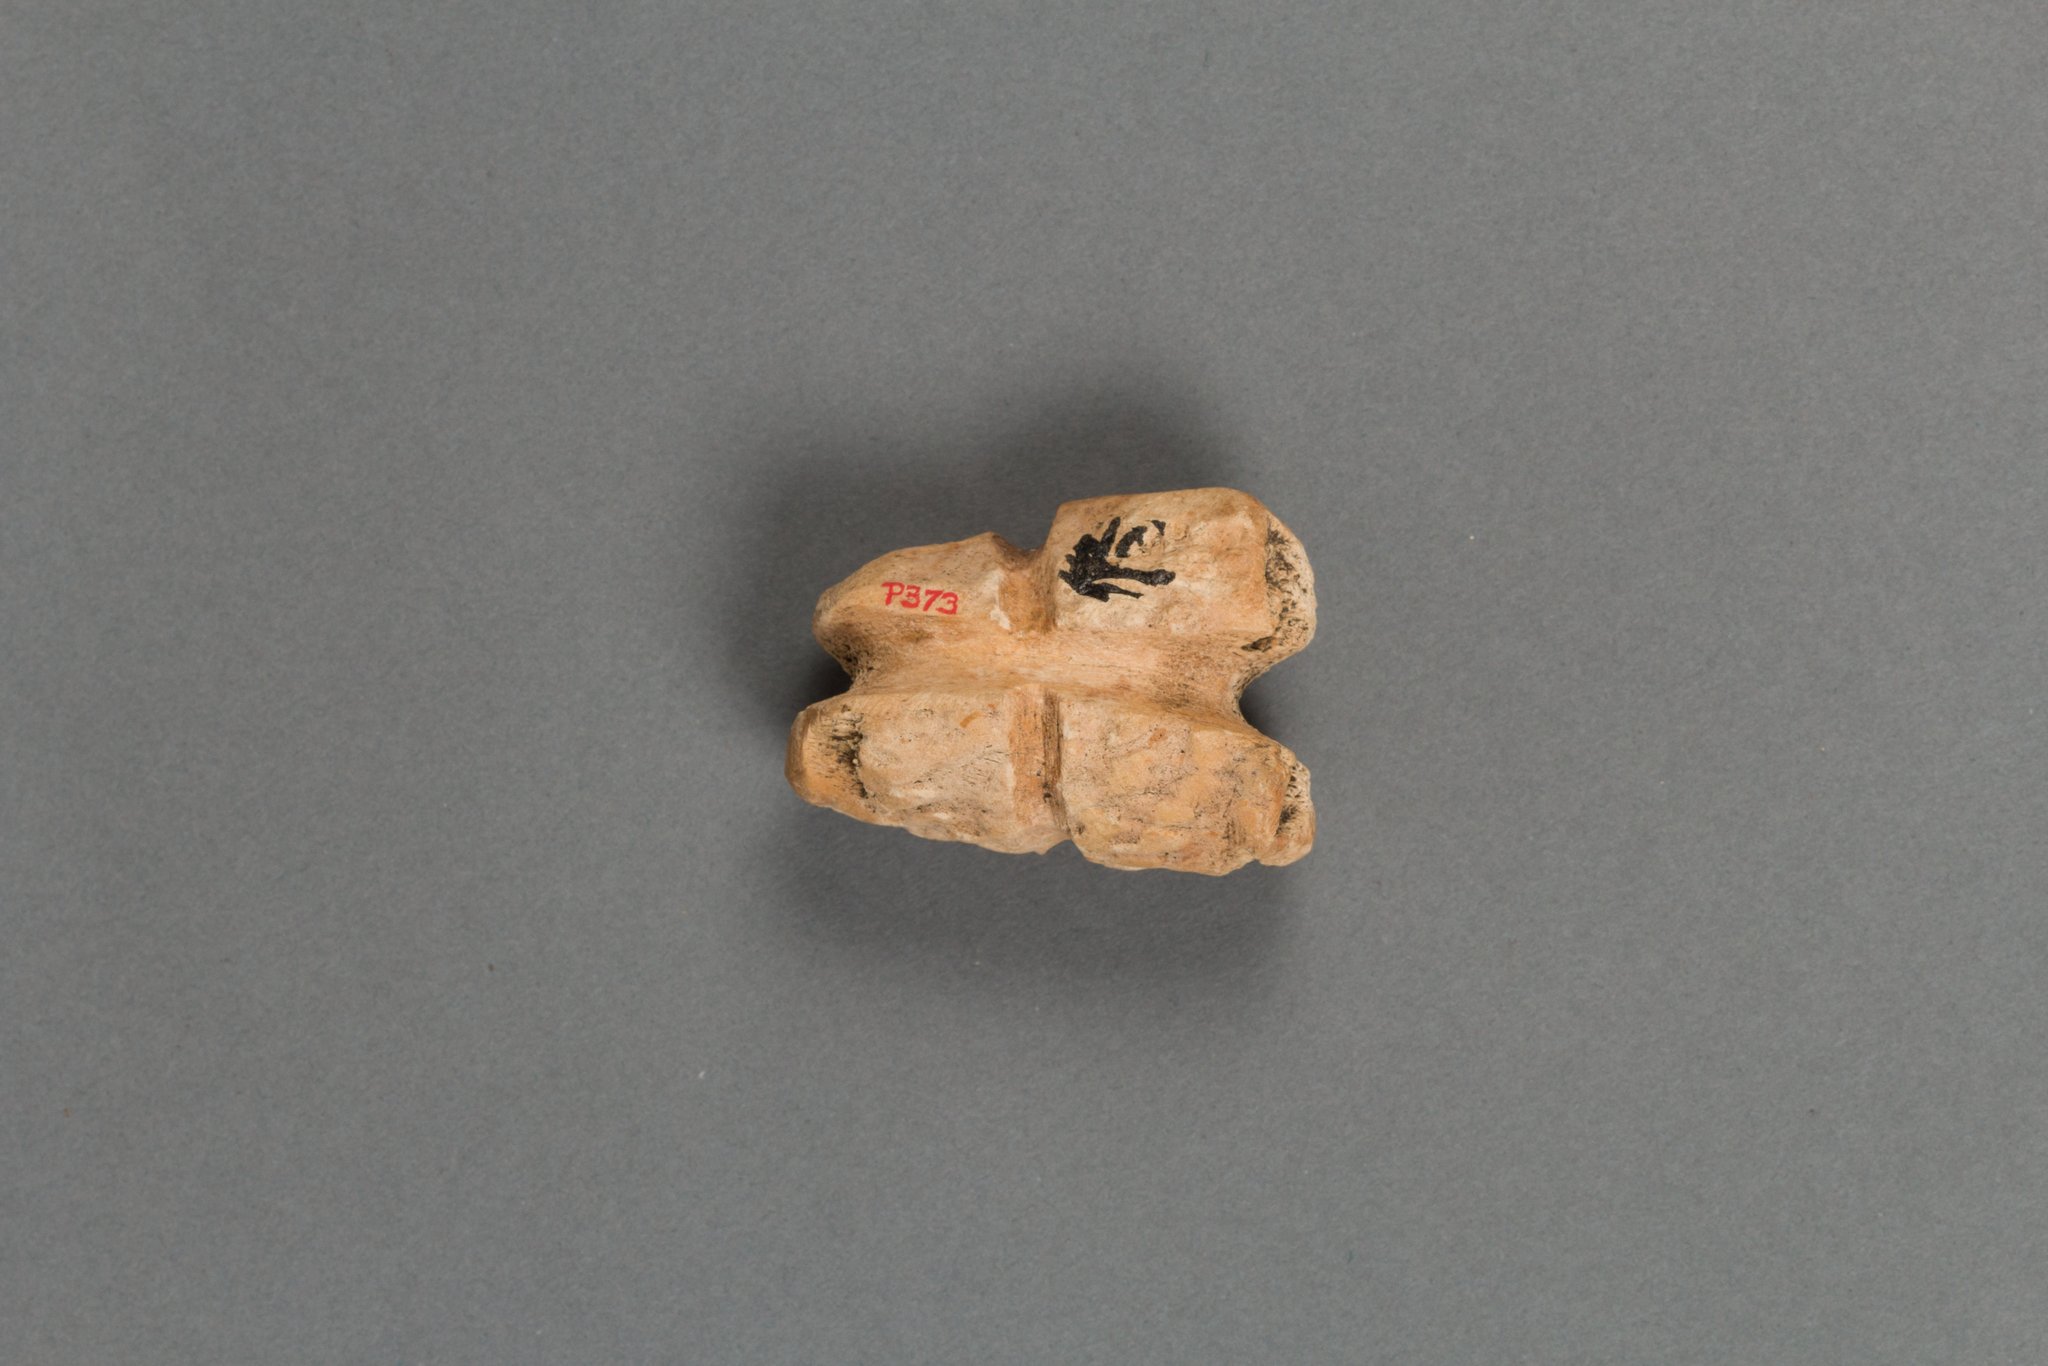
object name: fishnet sinker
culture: japanese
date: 1200-200 BCE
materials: bone